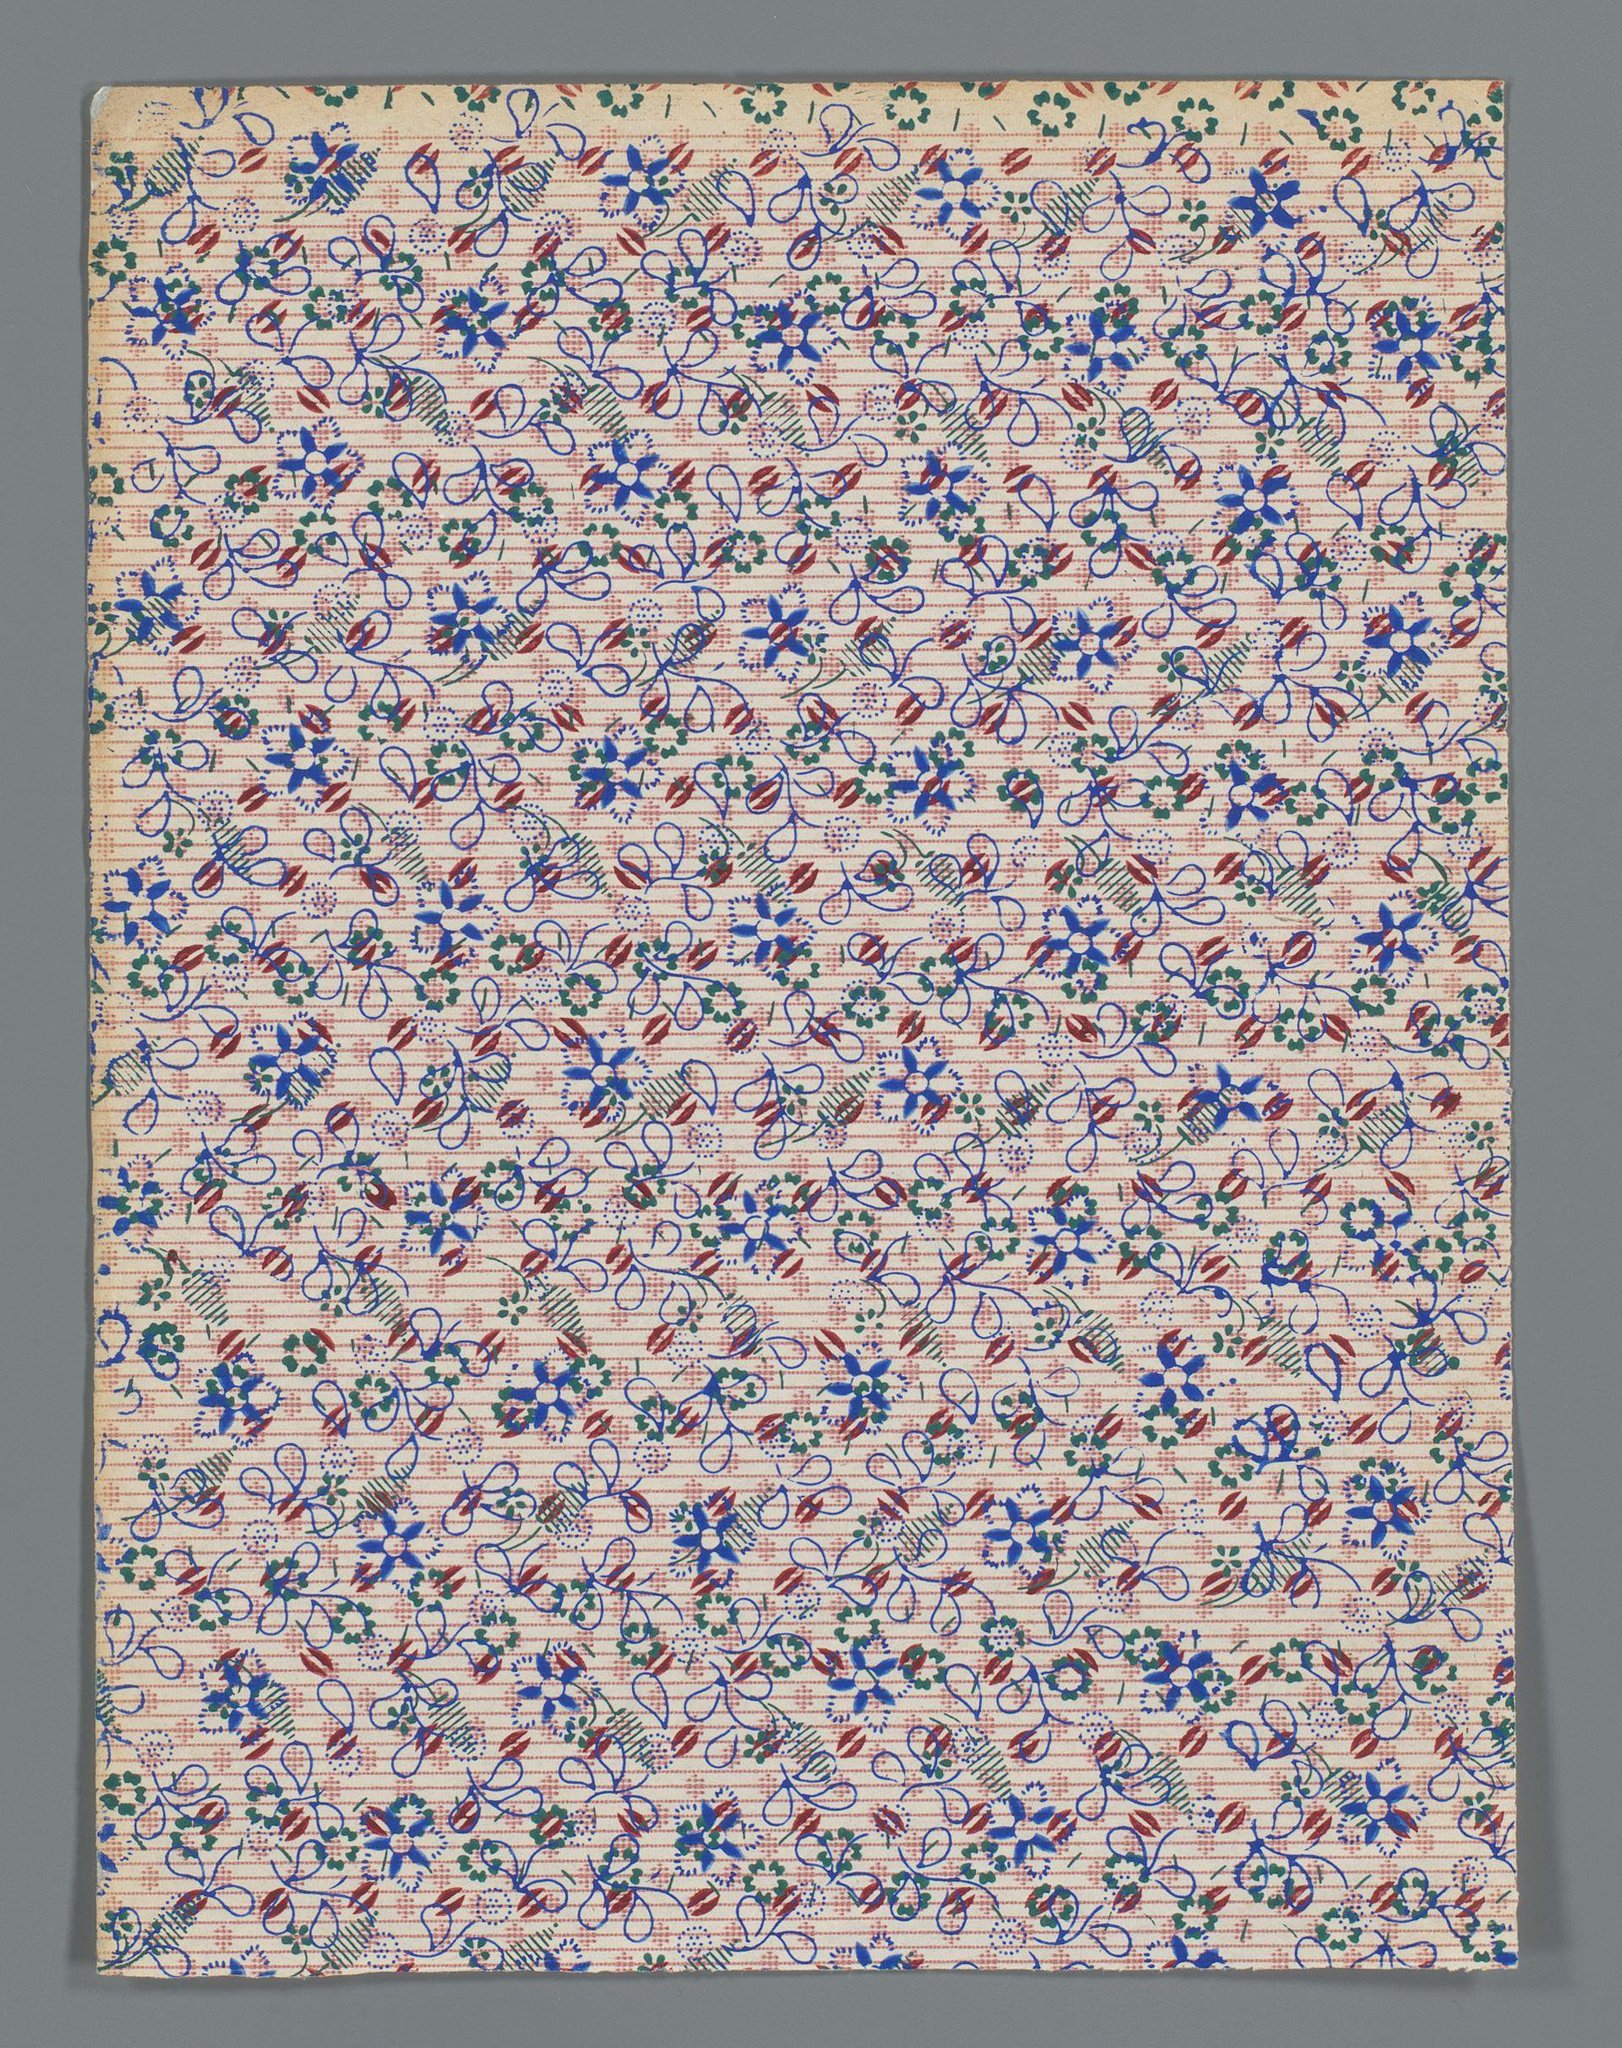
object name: printed paper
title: Blad met strooipatroon van gestileerde bloemen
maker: Anonymous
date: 1900-1970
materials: ink, paper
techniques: printing block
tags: ornament derived from plant forms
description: Blad met strooipatroon van gestileerde bloemen over een verticaal lijnenfond.